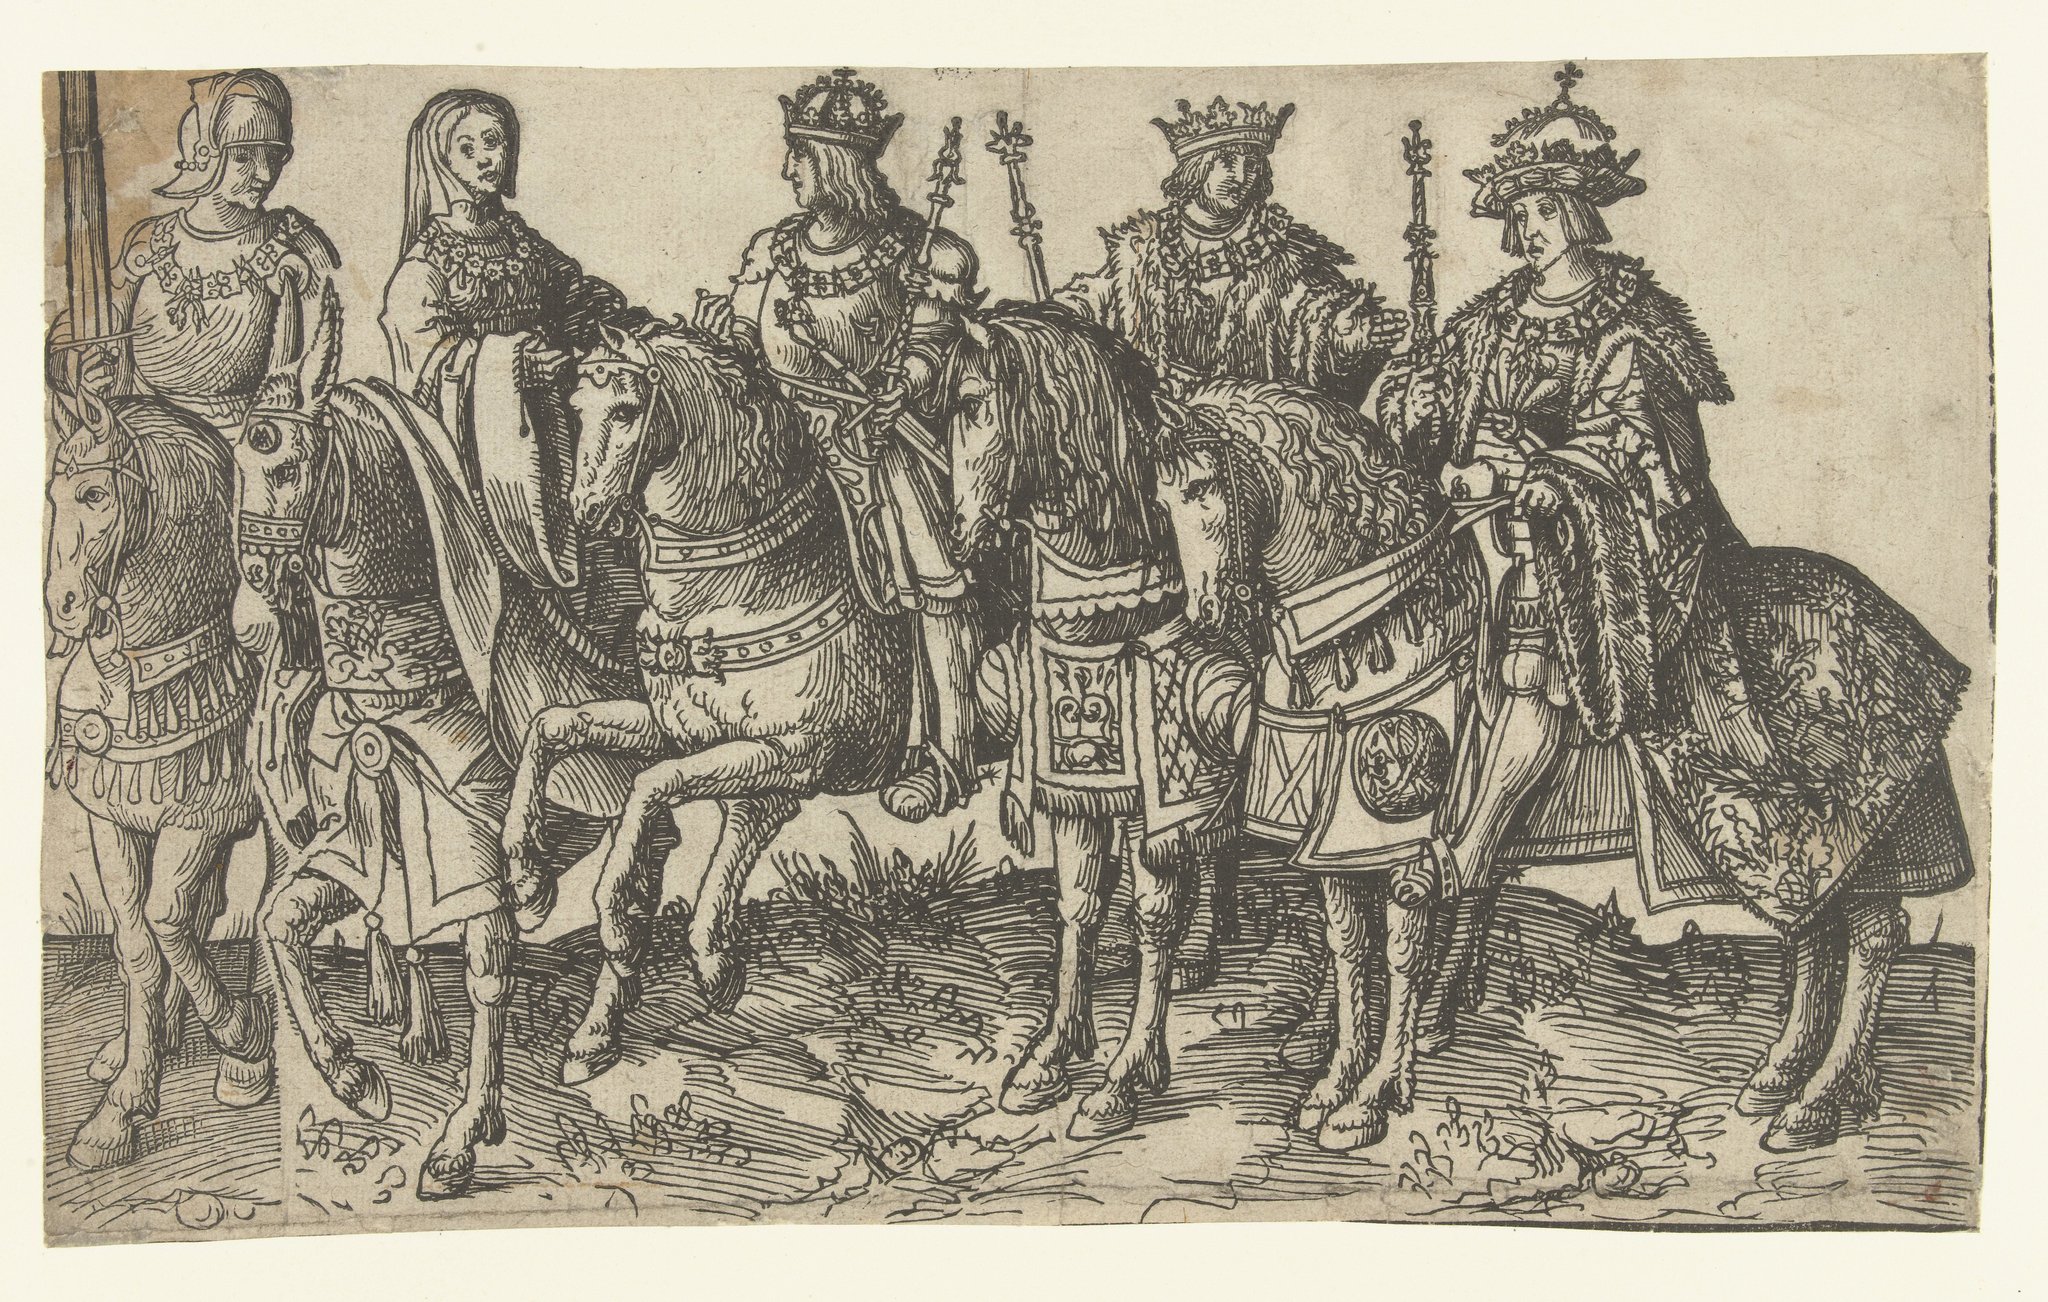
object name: print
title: De Graven en Gravinnen van Holland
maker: jacob cornelisz van oostsanen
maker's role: draughtsman, painter, print maker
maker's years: 1475-1533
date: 1519-1550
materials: paper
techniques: woodcut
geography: low countries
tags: brussels, maria (hertogin van bourgondië), earl, charles the bold (duke of burgundy), maximilian i (holy roman emperor), bruges, filips de schone (hertog van bourgondië), ghent, charles v (holy roman emperor and king of spain), equestrian state-portrait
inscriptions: collector's mark: Lugt 240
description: Twee uitgaven van de serie zijn bekend: één met Franse teksten en een titelblad met de naam van de uitgever Doen Pietersz. in Amsterdam en de dagtekening 1.4.1518, en één met Latijnse teksten, waarvan het titelblad ontbreekt, op het laatste blad opgedragen aan Karel V. Fragmenten van de later versneden blokken werden opgenomen in de "Cronicke van Brabant", Antwerpen 1530, door Jan van Doesborch.